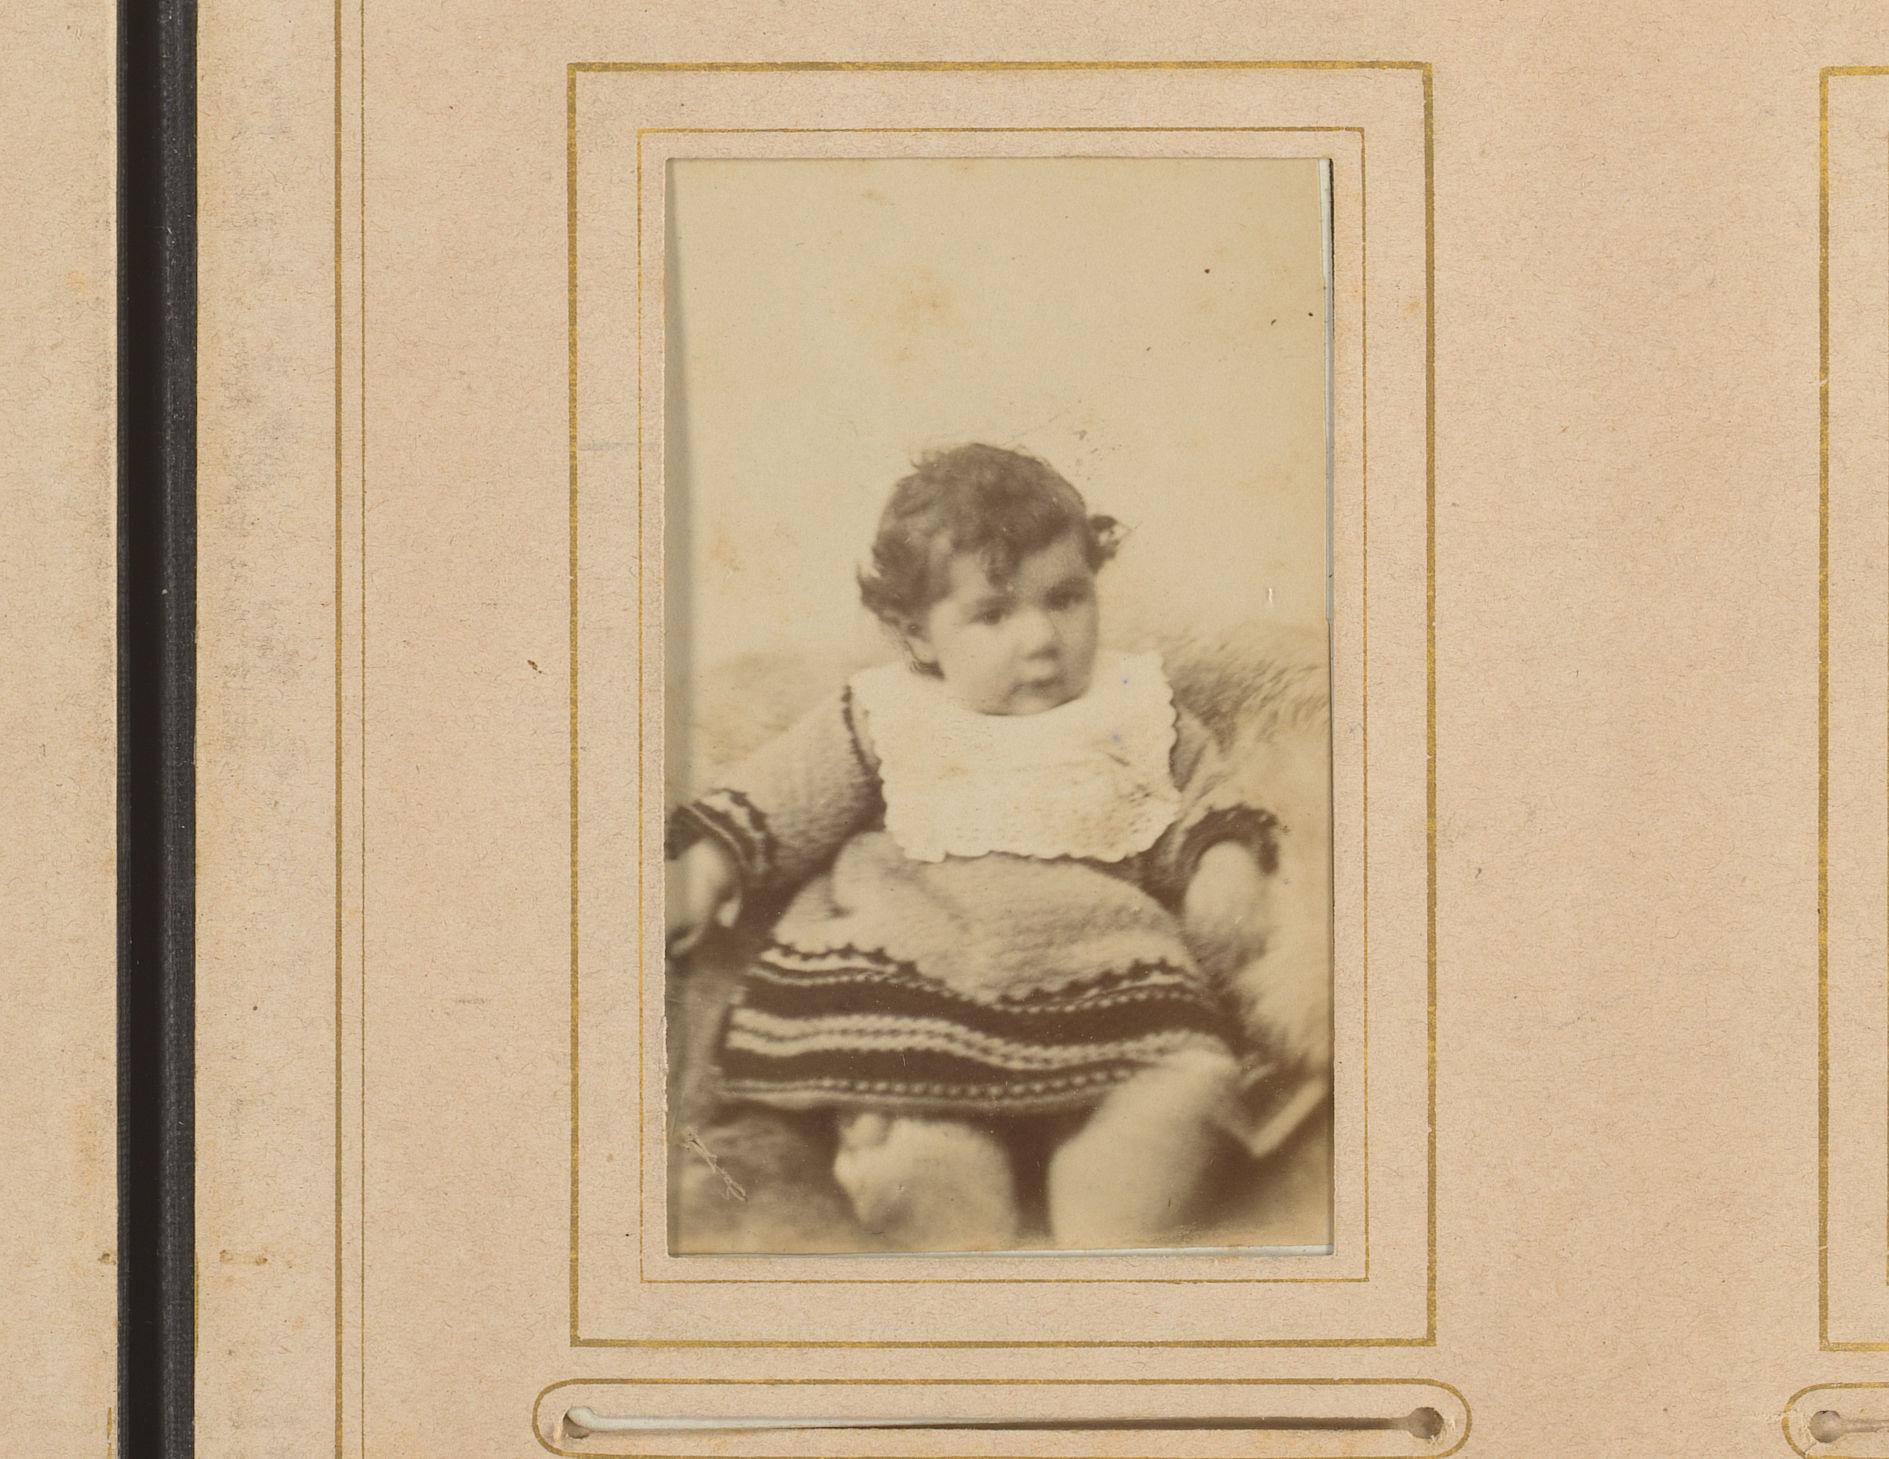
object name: carte de visite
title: Portret van een baby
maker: léon rousseaux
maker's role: fotograaf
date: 1880-1910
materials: cardboard, photographic support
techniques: albumen print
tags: historical persons, infant, baby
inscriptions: inscription: ‘Agrandissement/ Photographie/ au platine/ et sur porcelaine/ spécialités/ portraits d'enfants (...)’, name: ‘Léon Rousseaux 2 Rue Leys 2 Anvers’